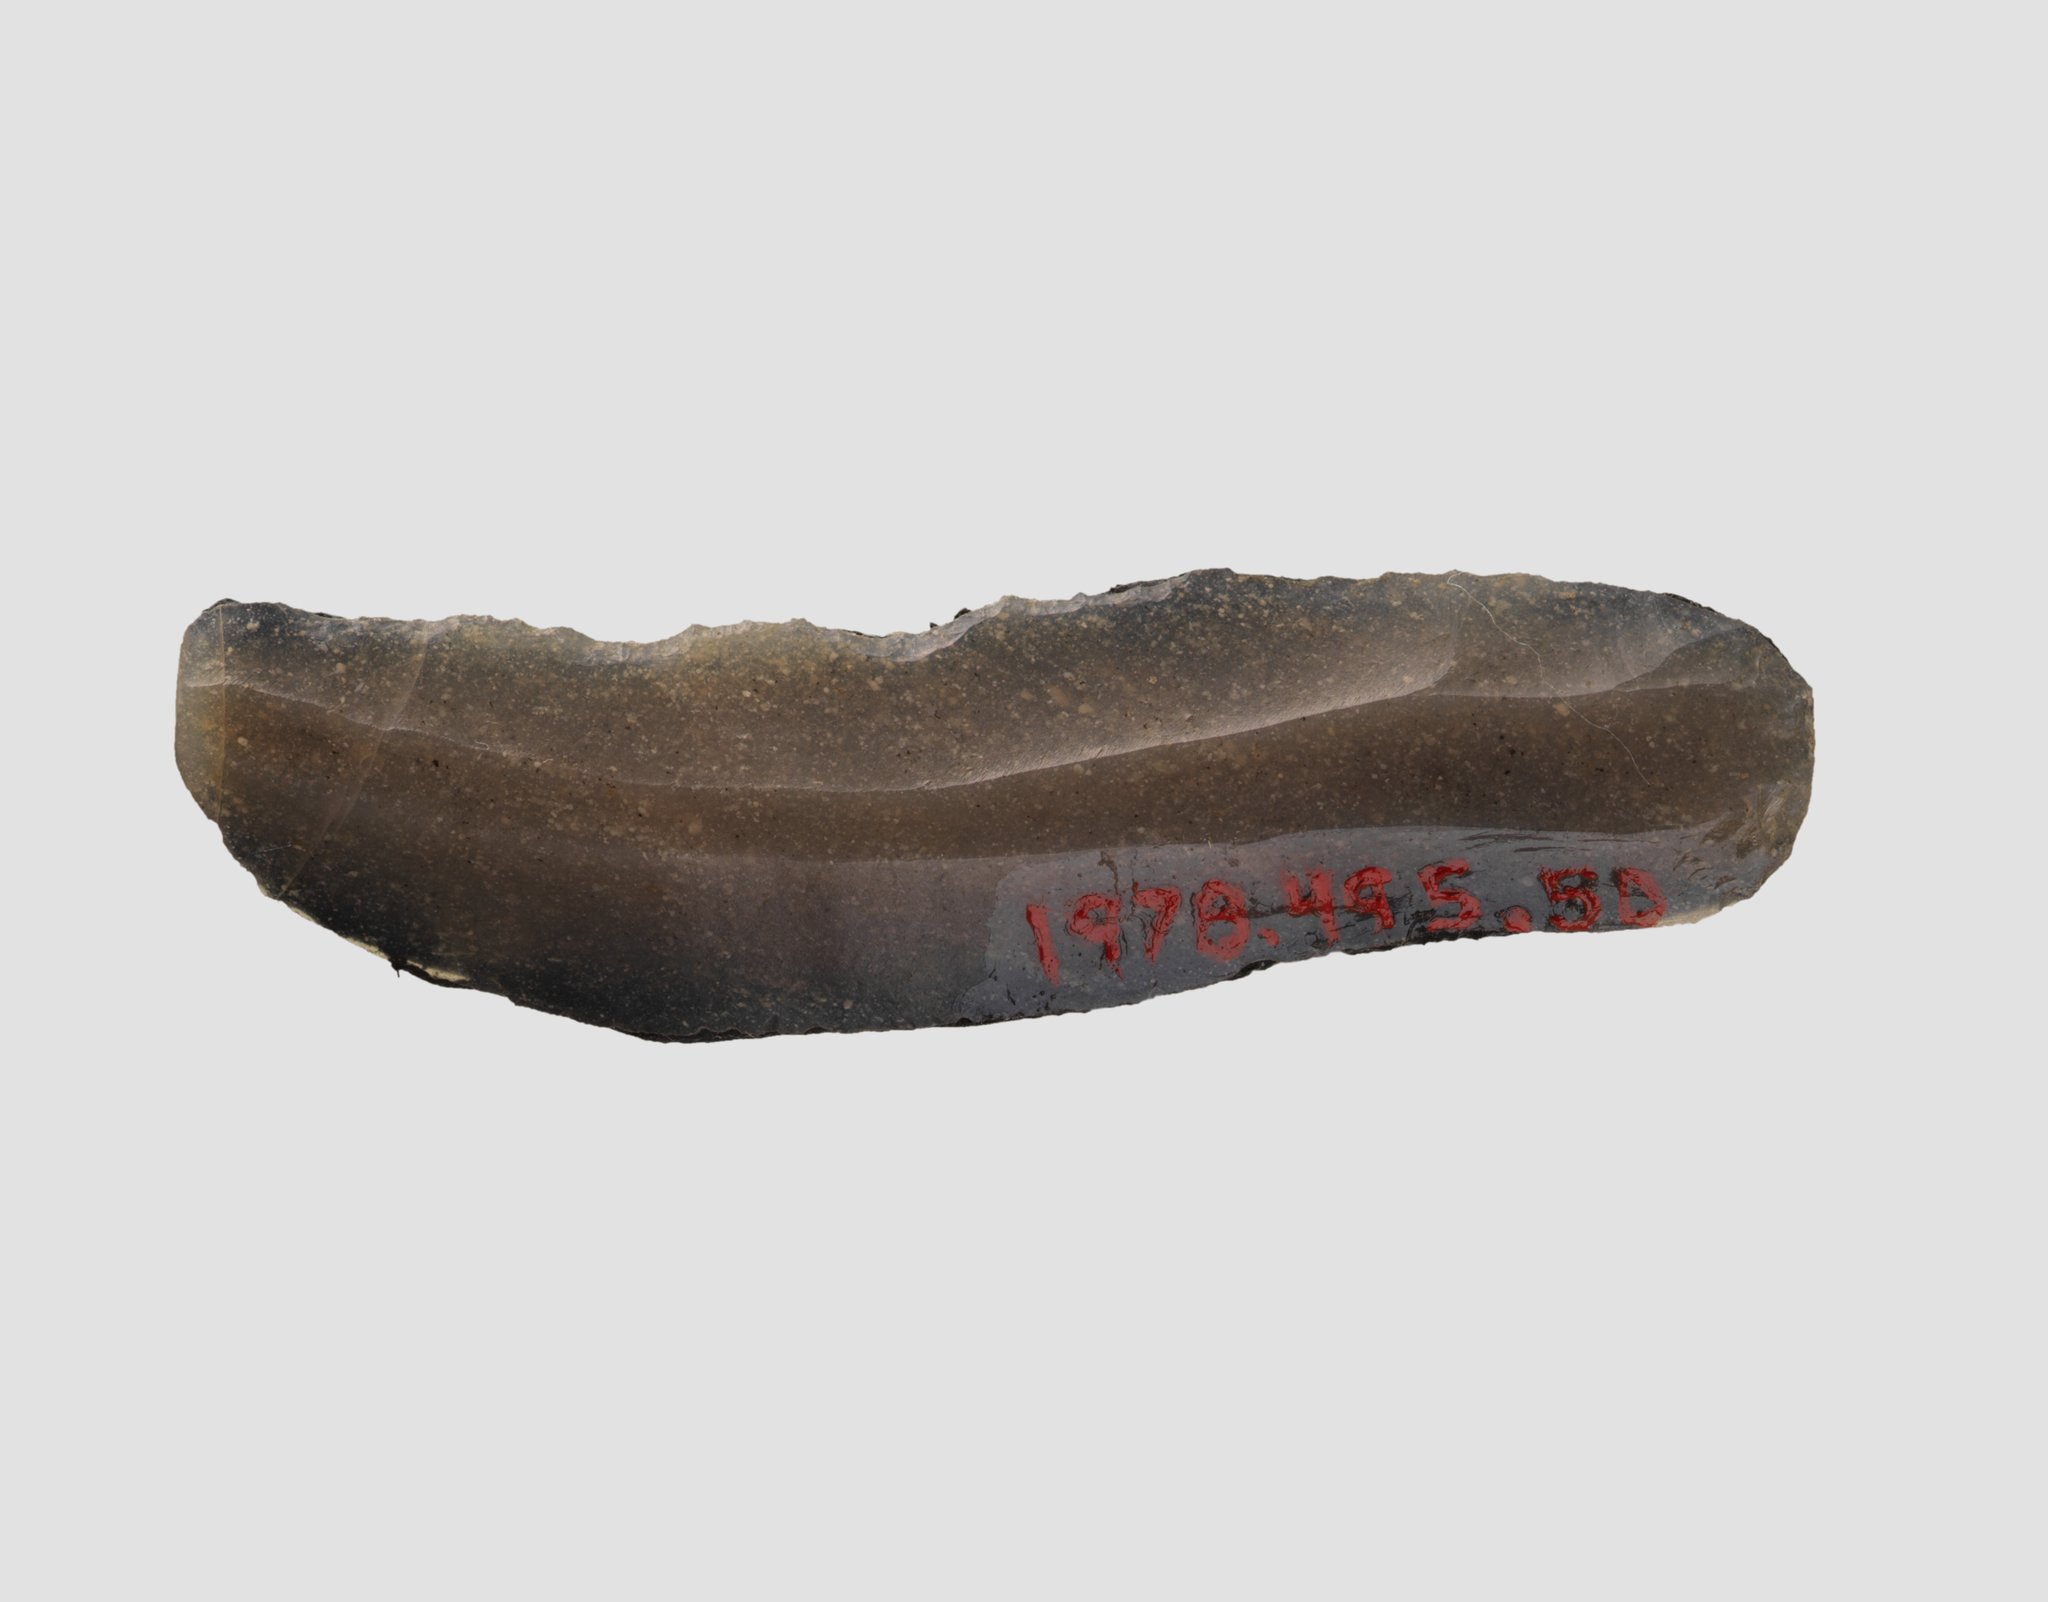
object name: knife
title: Blade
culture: ghassulian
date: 4600-3600 BCE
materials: stone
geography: levant